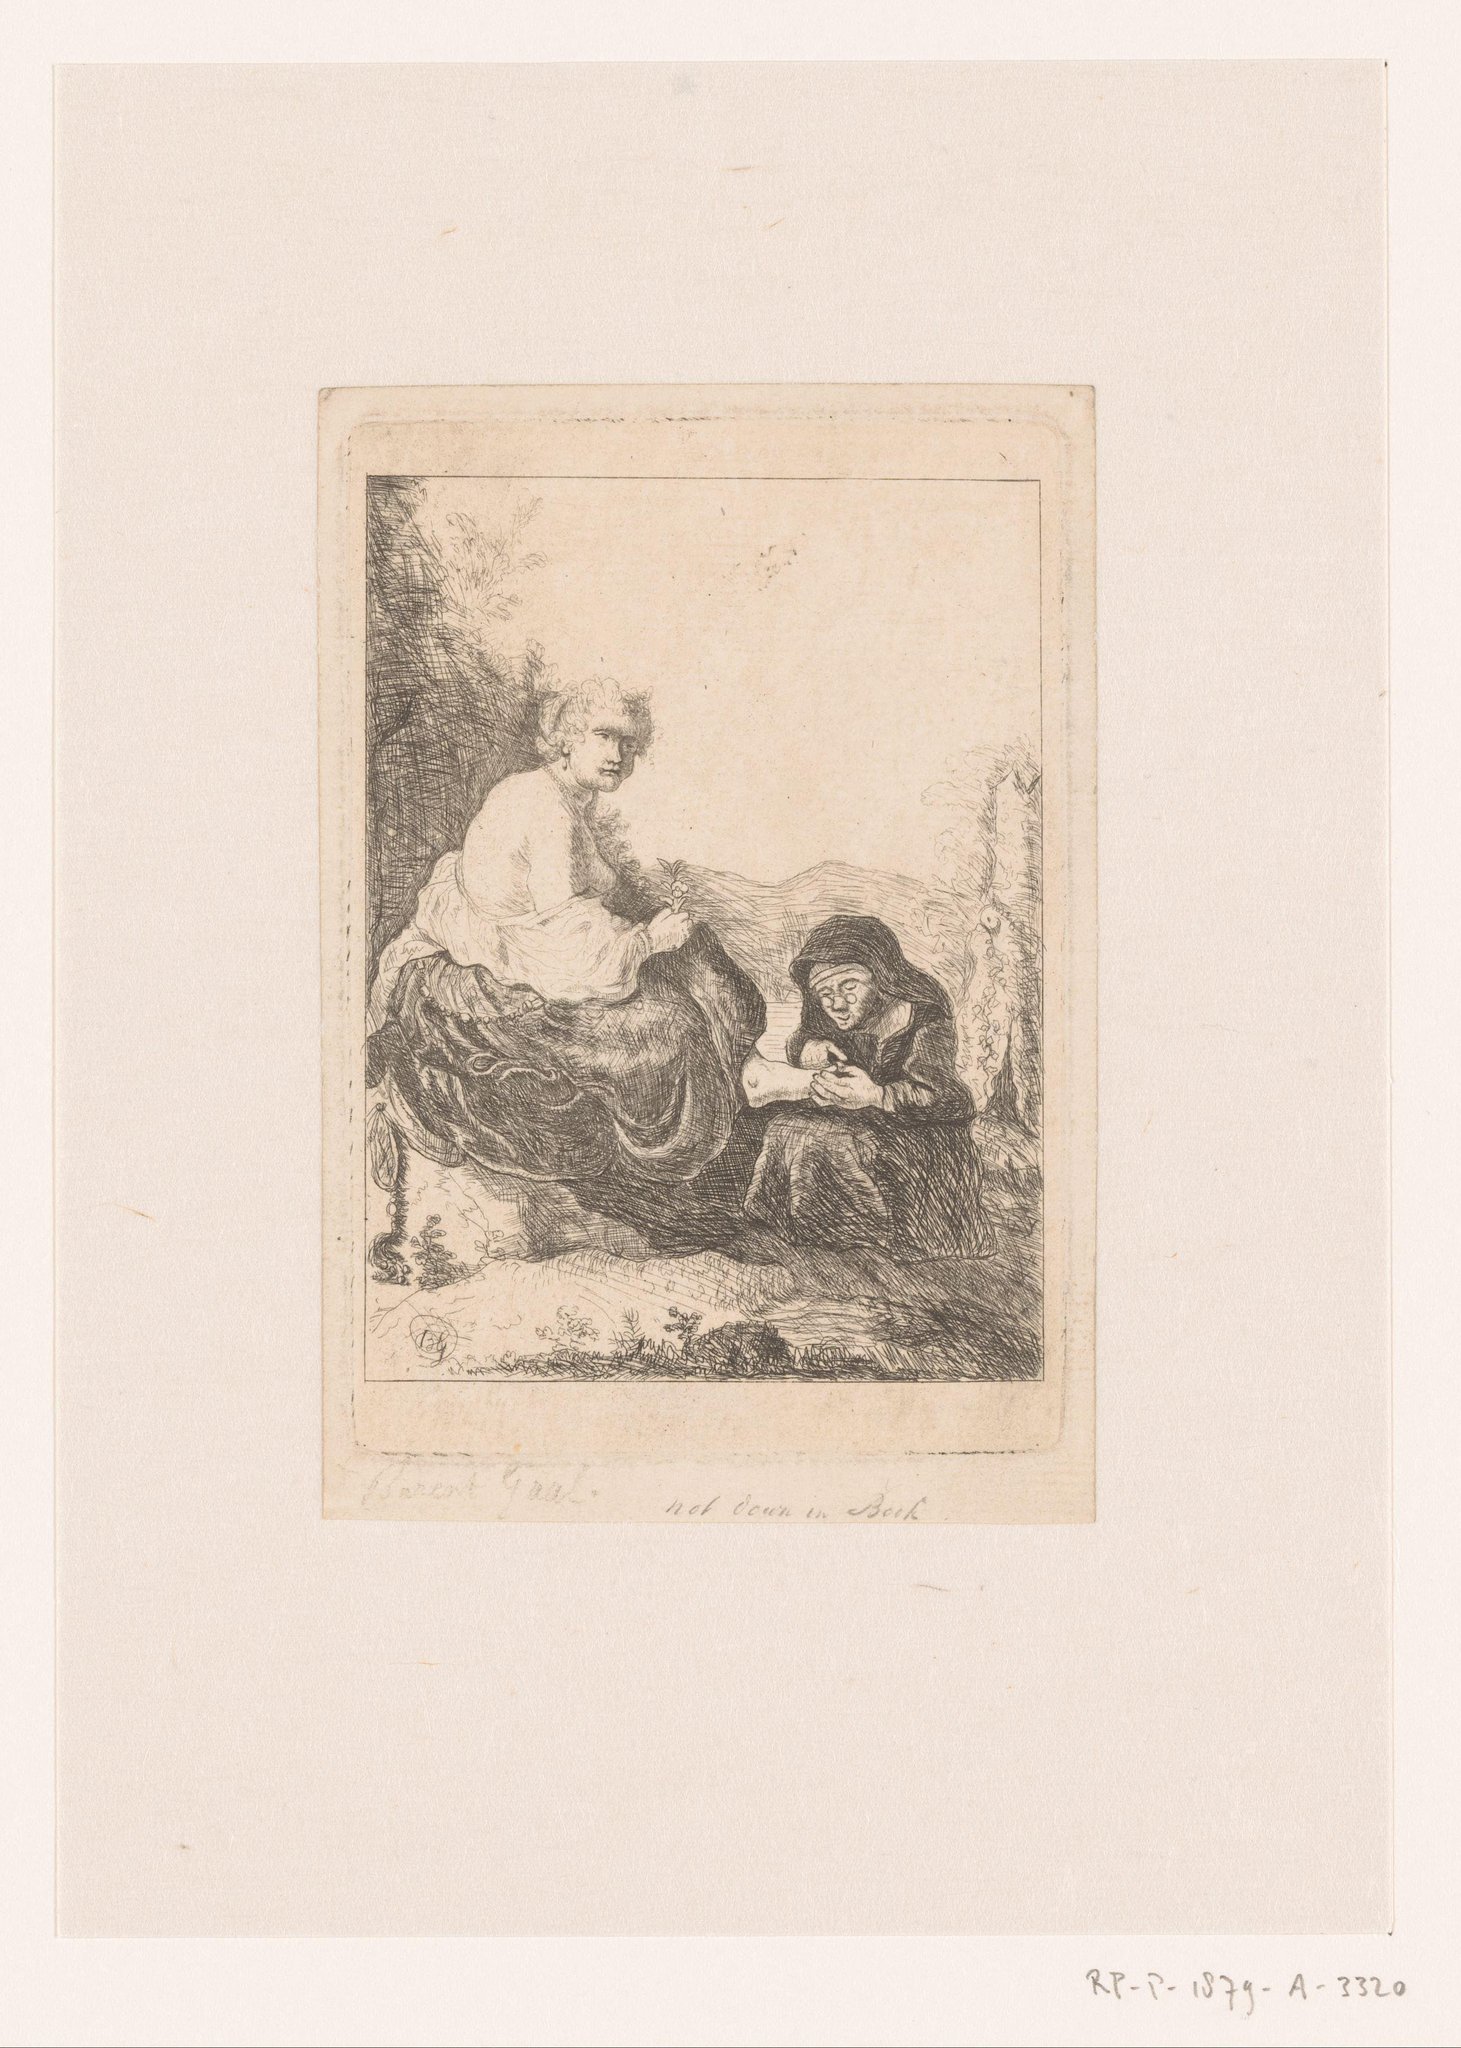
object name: print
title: Toilet van Batseba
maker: monogrammist bg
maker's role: print maker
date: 1700-1799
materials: paper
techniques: etching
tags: nails (toes), the (nude) human figure; 'corpo humano' (ripa) (+ old female (human being)), bathsheba attended by servant(s)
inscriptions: inscription: ‘B. Graat’, inscription: ‘Barent Gaal’, inscription: ‘not down in Book’, collector's mark: Lugt 2228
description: Spiegelbeeldige kopie naar een prent van een leerling van Rembrandt.